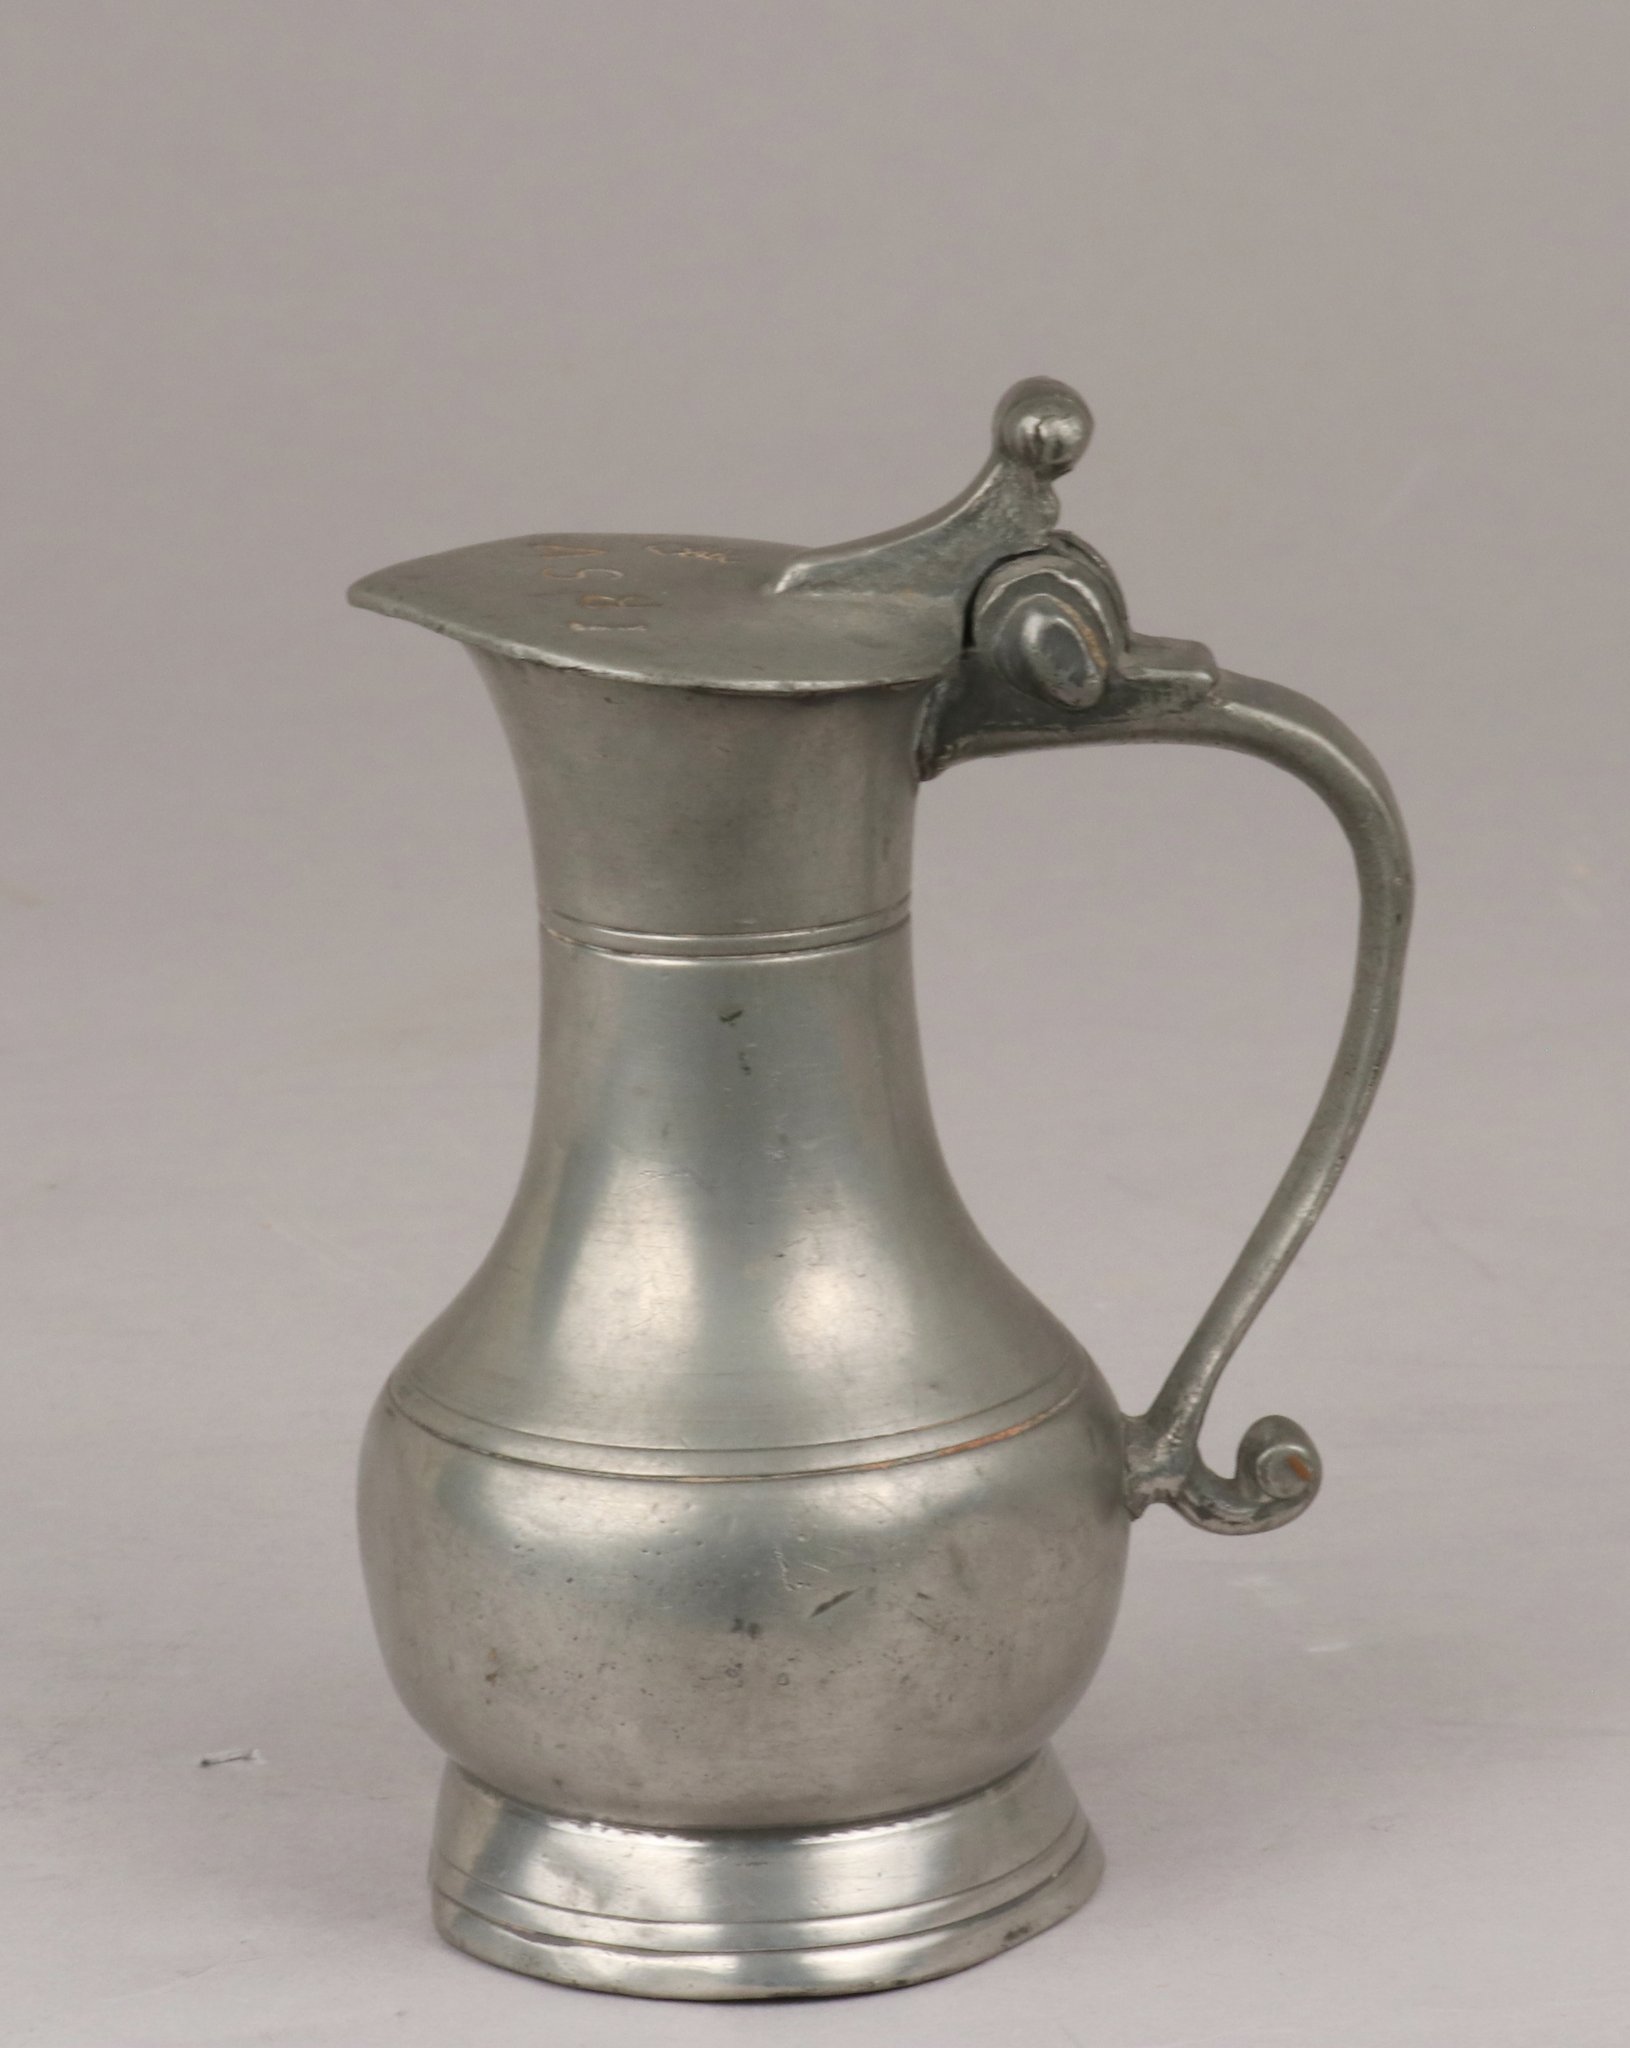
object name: measure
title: Alcohol measure "Demoiselle"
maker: robert toussaint baillard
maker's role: maker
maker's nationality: french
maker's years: 1743-1786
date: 1743-1779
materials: pewter